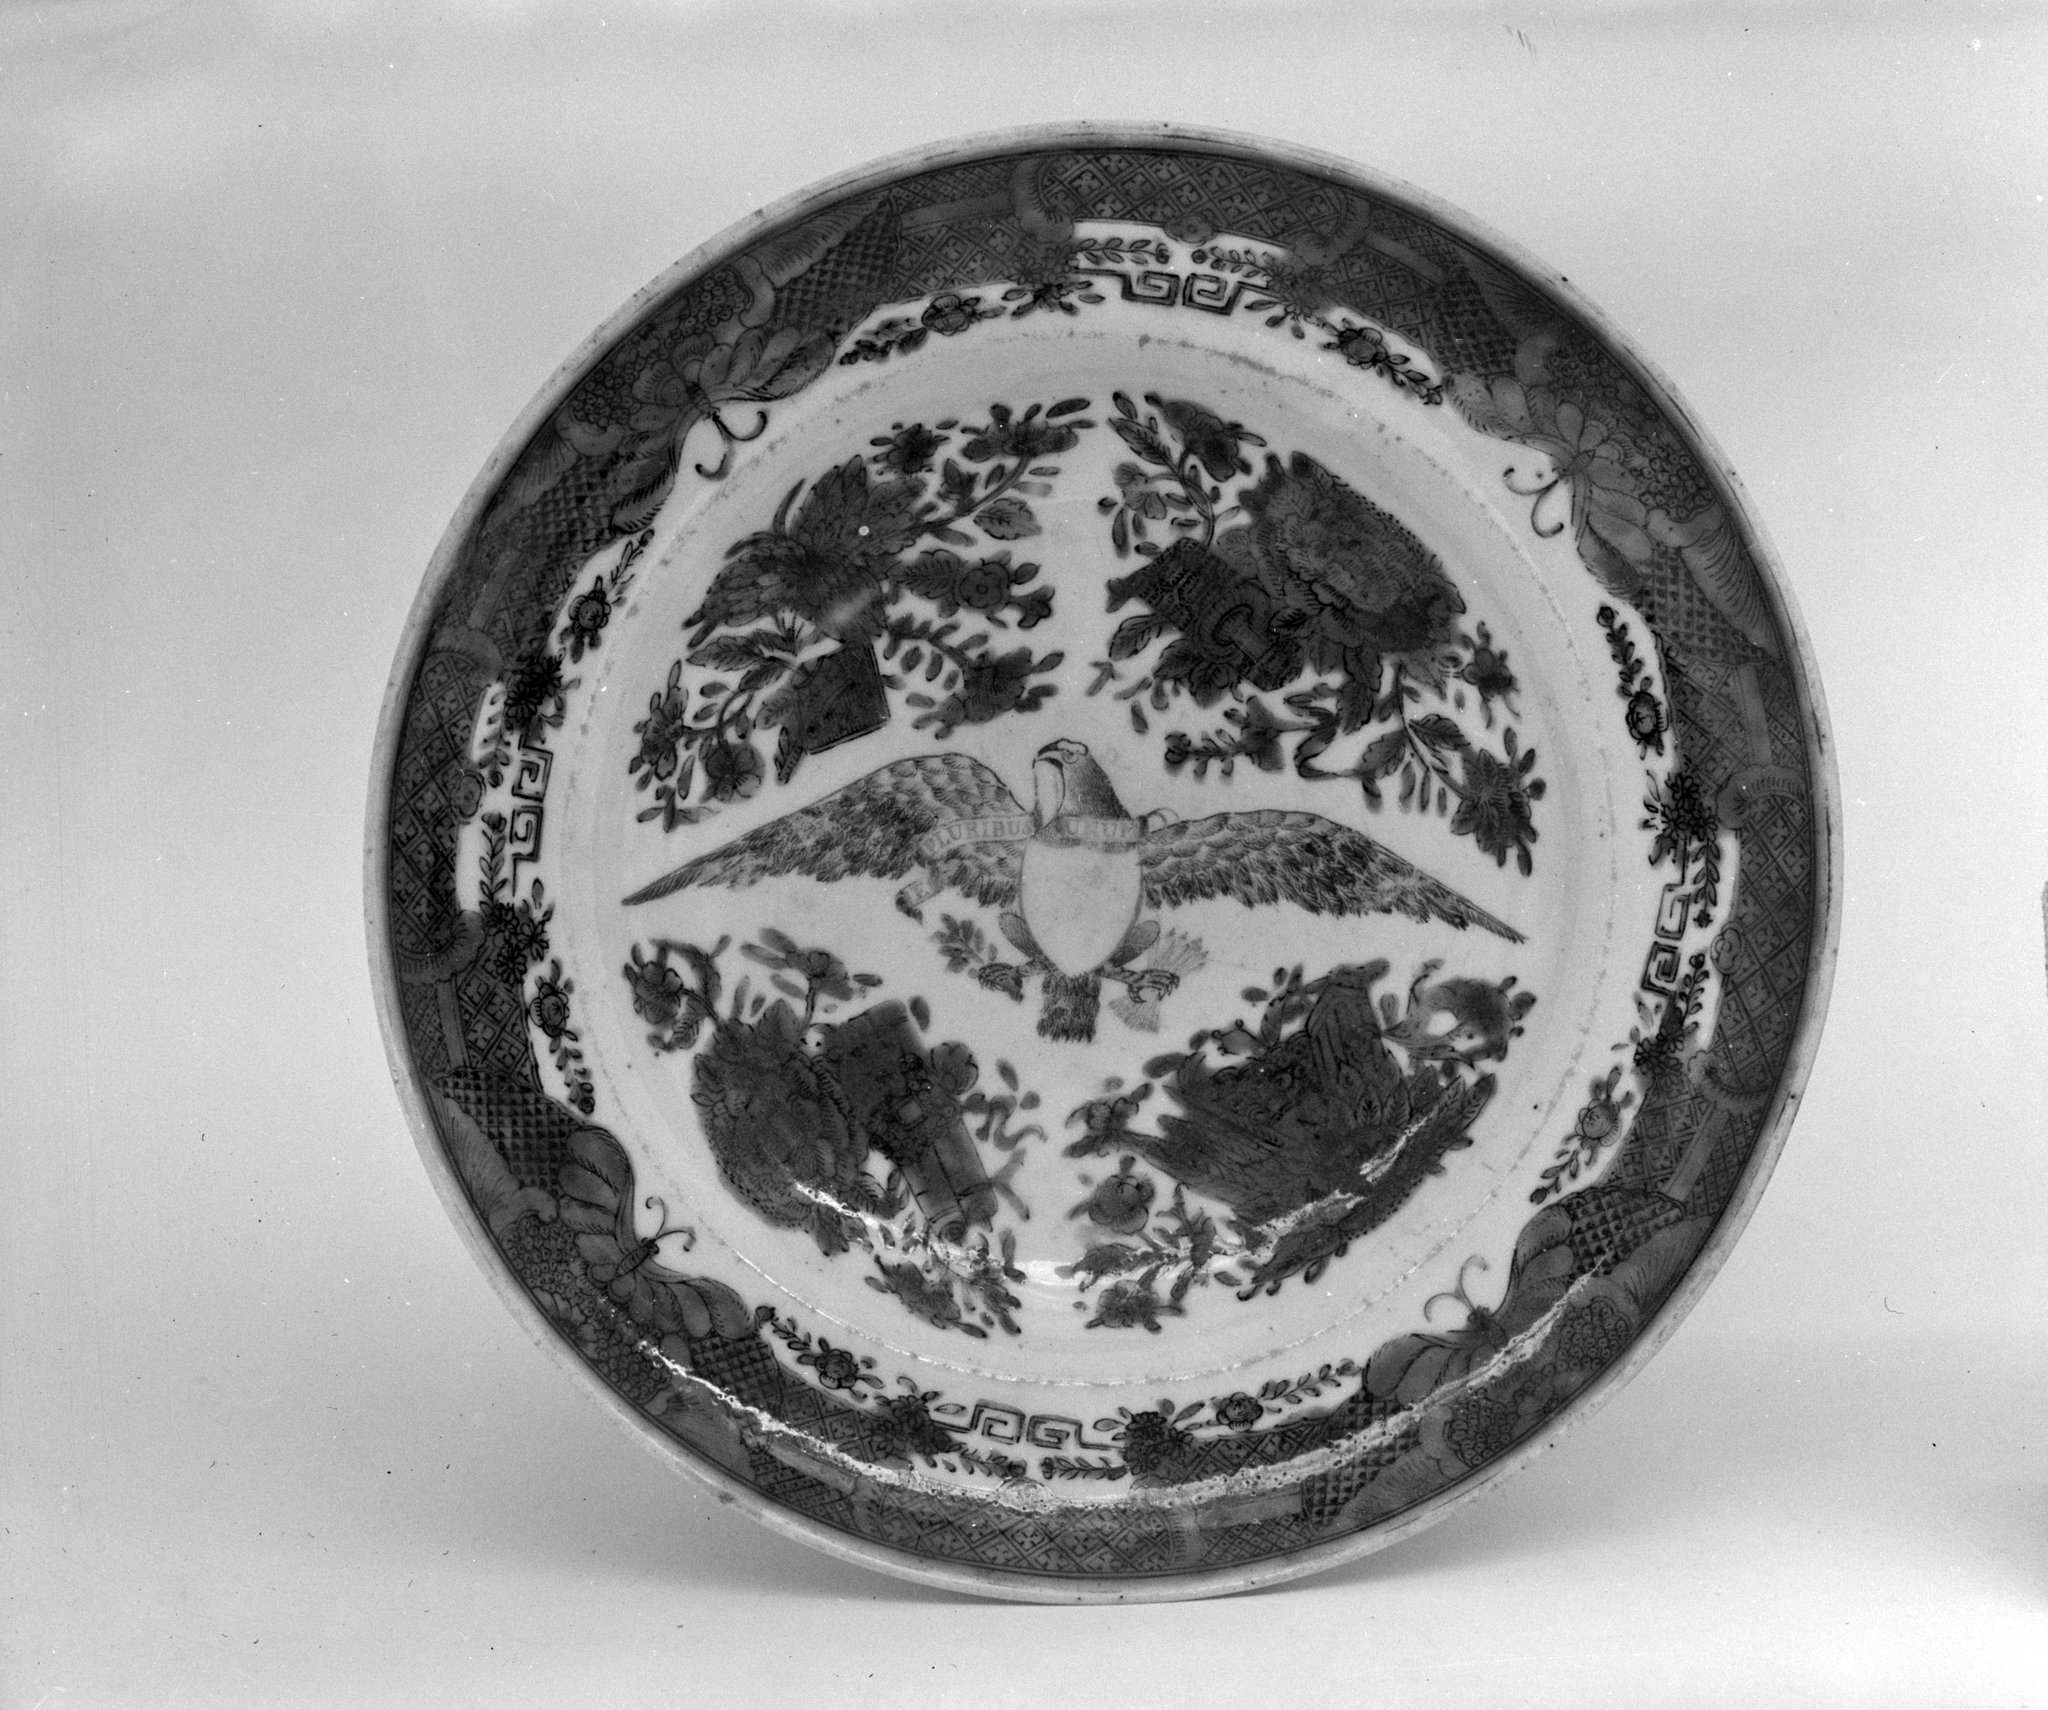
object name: dish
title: Dish (part of a service)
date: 1801-1833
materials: hard paste porcelain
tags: birds,butterflies